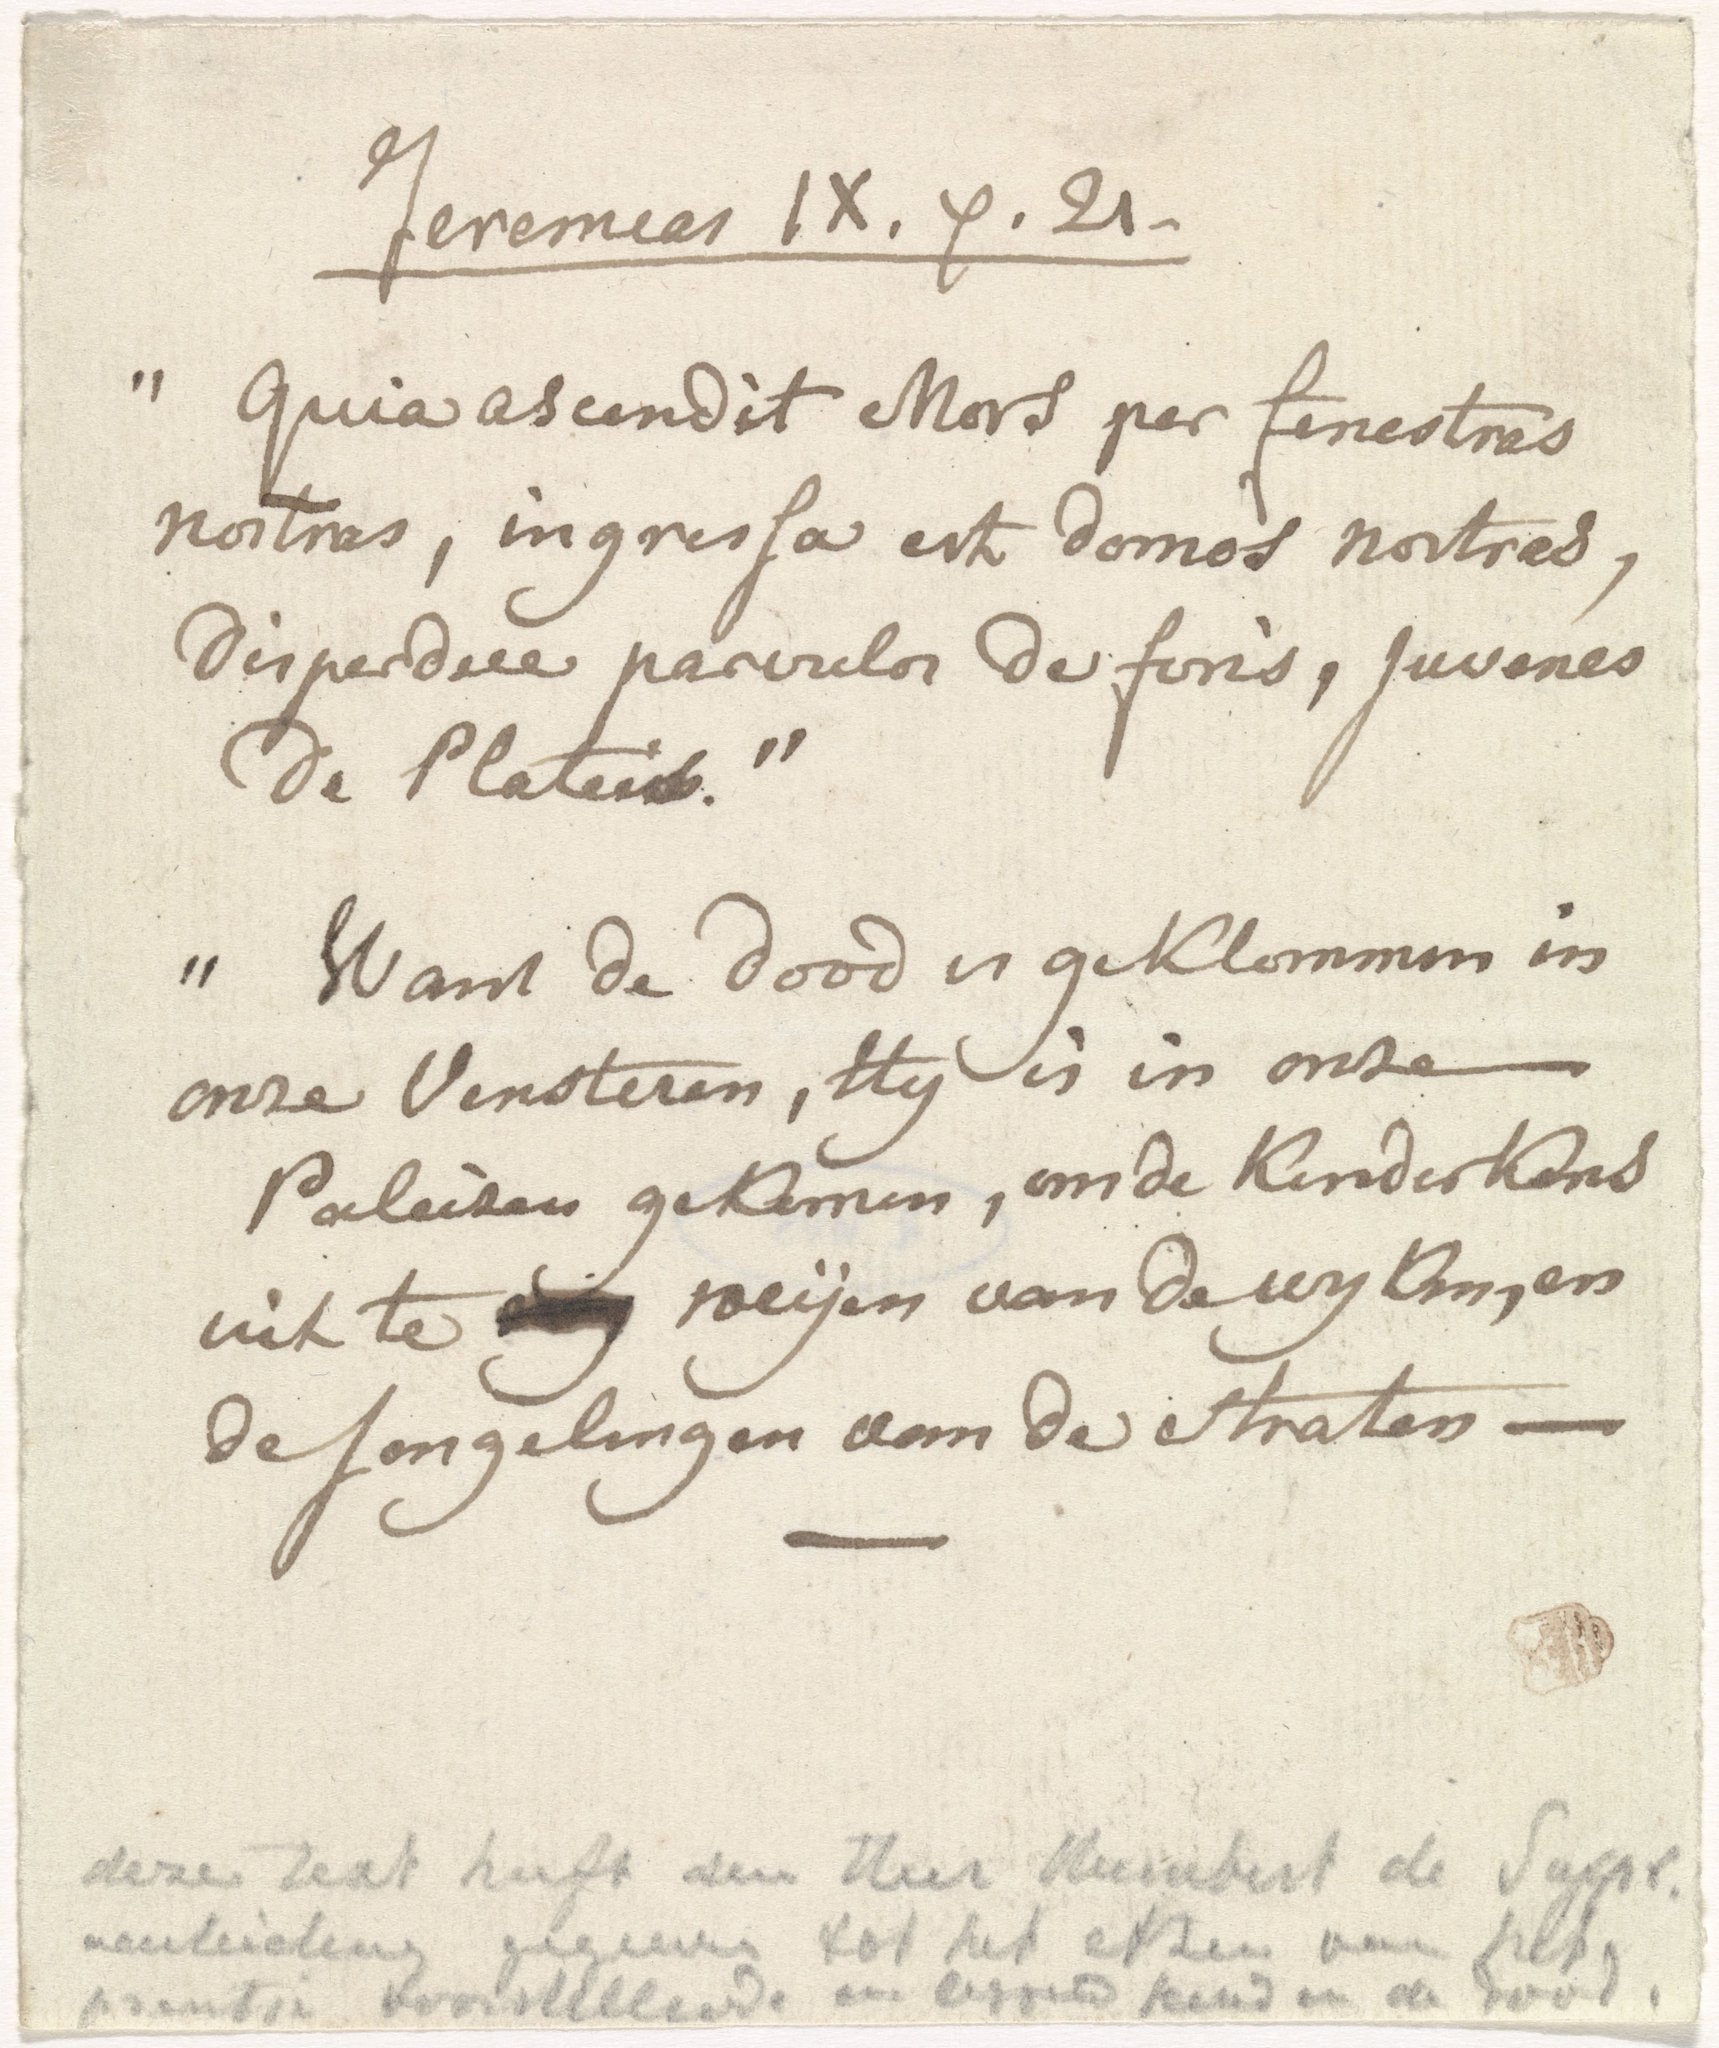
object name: document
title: Aantekening bij allegorische waarschuwing tegen onanie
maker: Anonymous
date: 1801-1937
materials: paper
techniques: writing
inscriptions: collector's mark: Lugt 2760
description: Het bijbelvers Jer. 9:20 in het Latijn en het Nederlands met inkt geschreven. Onder in potlood: deze text heeft den Heer Humbert de Suppv. aanleiding gegeeven tot het etzen van het prentje voorstellende een liggend kind en de dood.